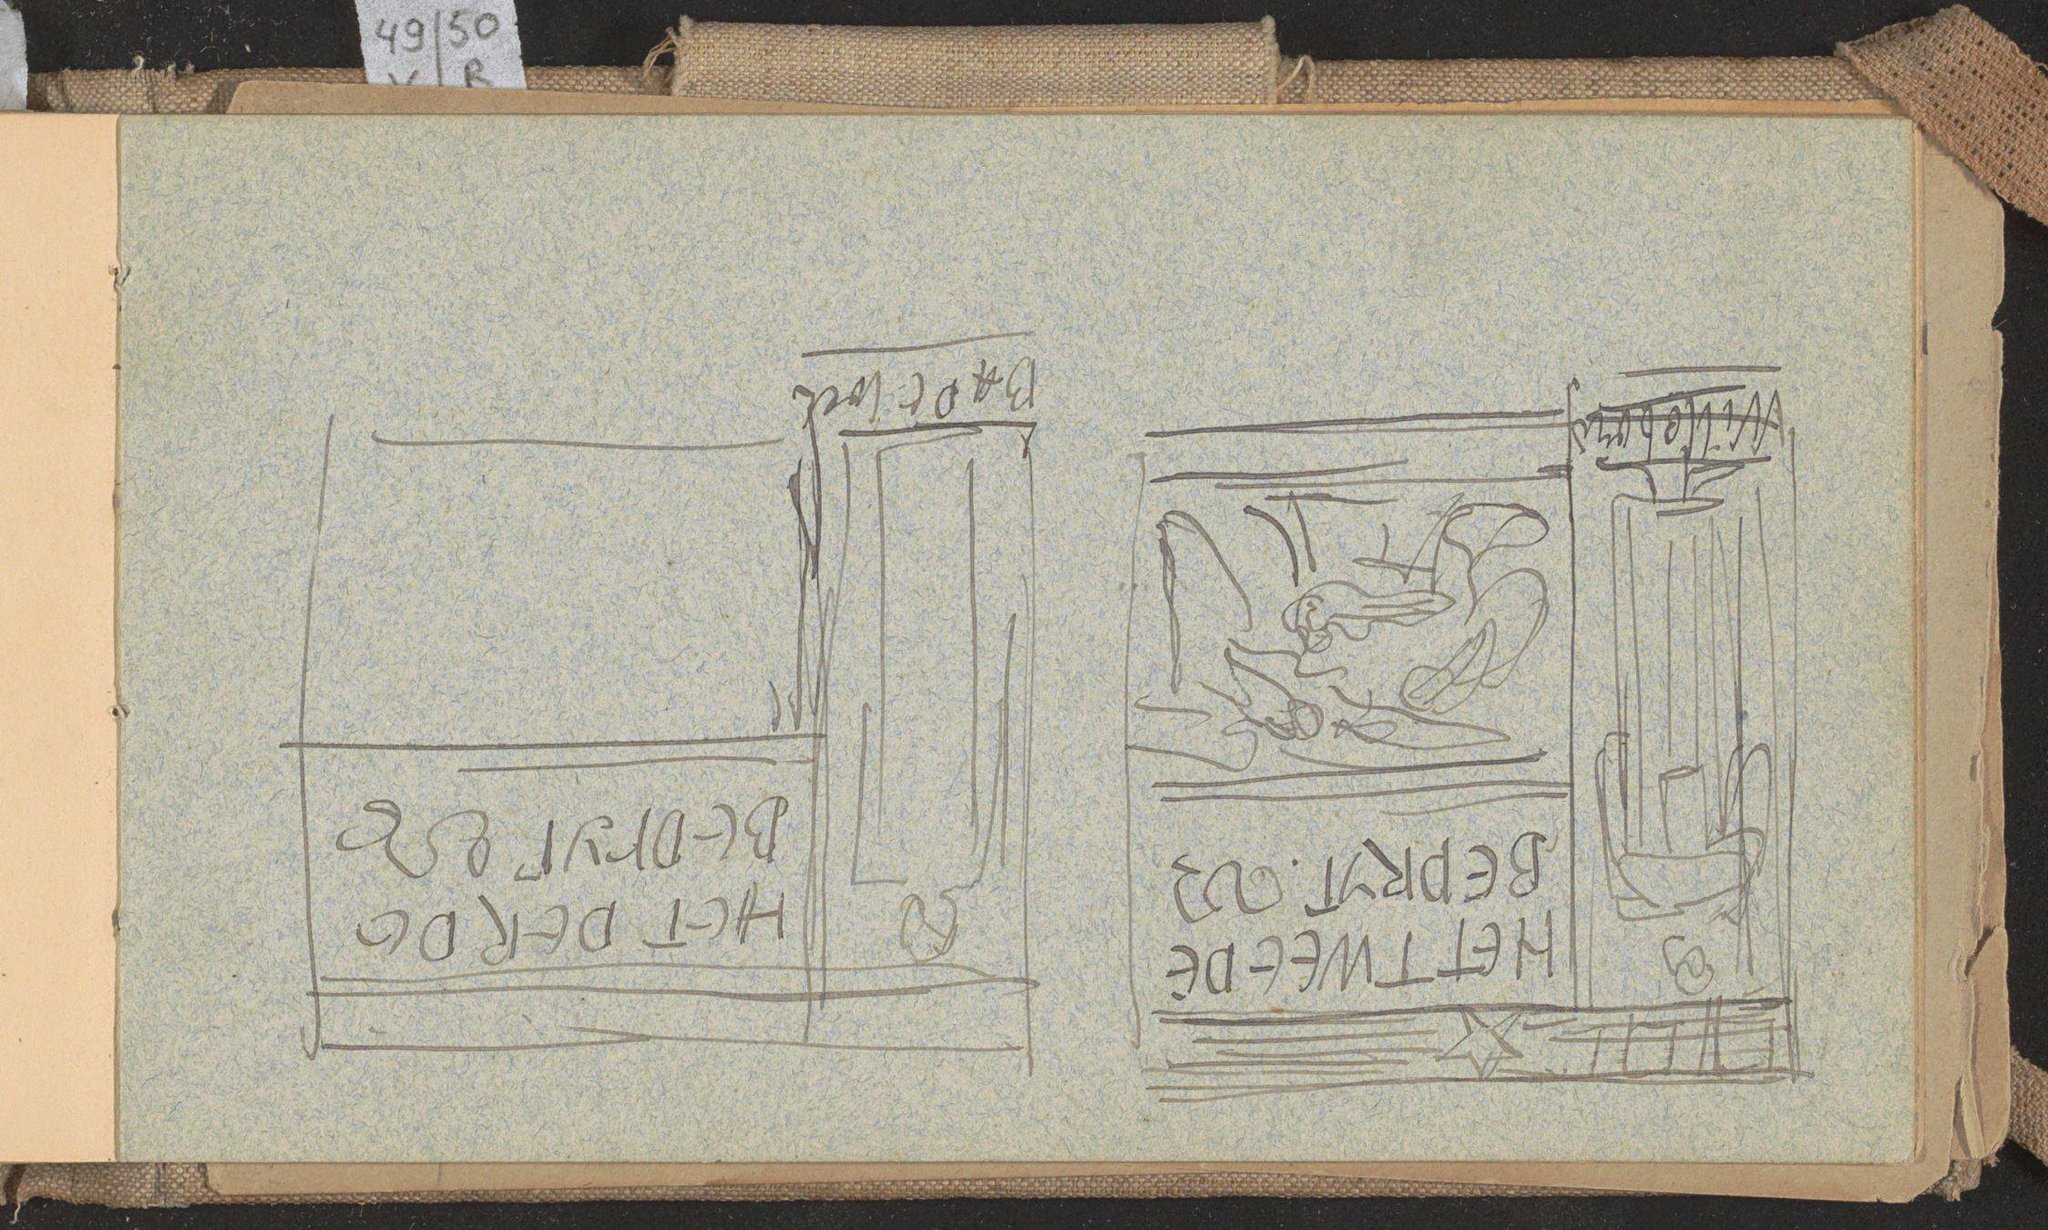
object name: sketchbook leaf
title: Boekontwerp voor 'Gijsbrecht van Aemstel' van Joost van den Vondel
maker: antoon derkinderen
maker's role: draughtsman, painter, print maker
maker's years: 1859-1925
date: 1893-1901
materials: ink, paper, pencil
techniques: pen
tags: decoration of printed matter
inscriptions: annotation: ‘HET TWEEDE/ BEDRYF/ HET DERDE/ BEDRYF/ Willeborg/ BADC [...]oek’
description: Ontwerpen voor versierde pagina's met het tweede en derde bedrijf. Blad 45 recto uit een schetsboek met 51 bladen.